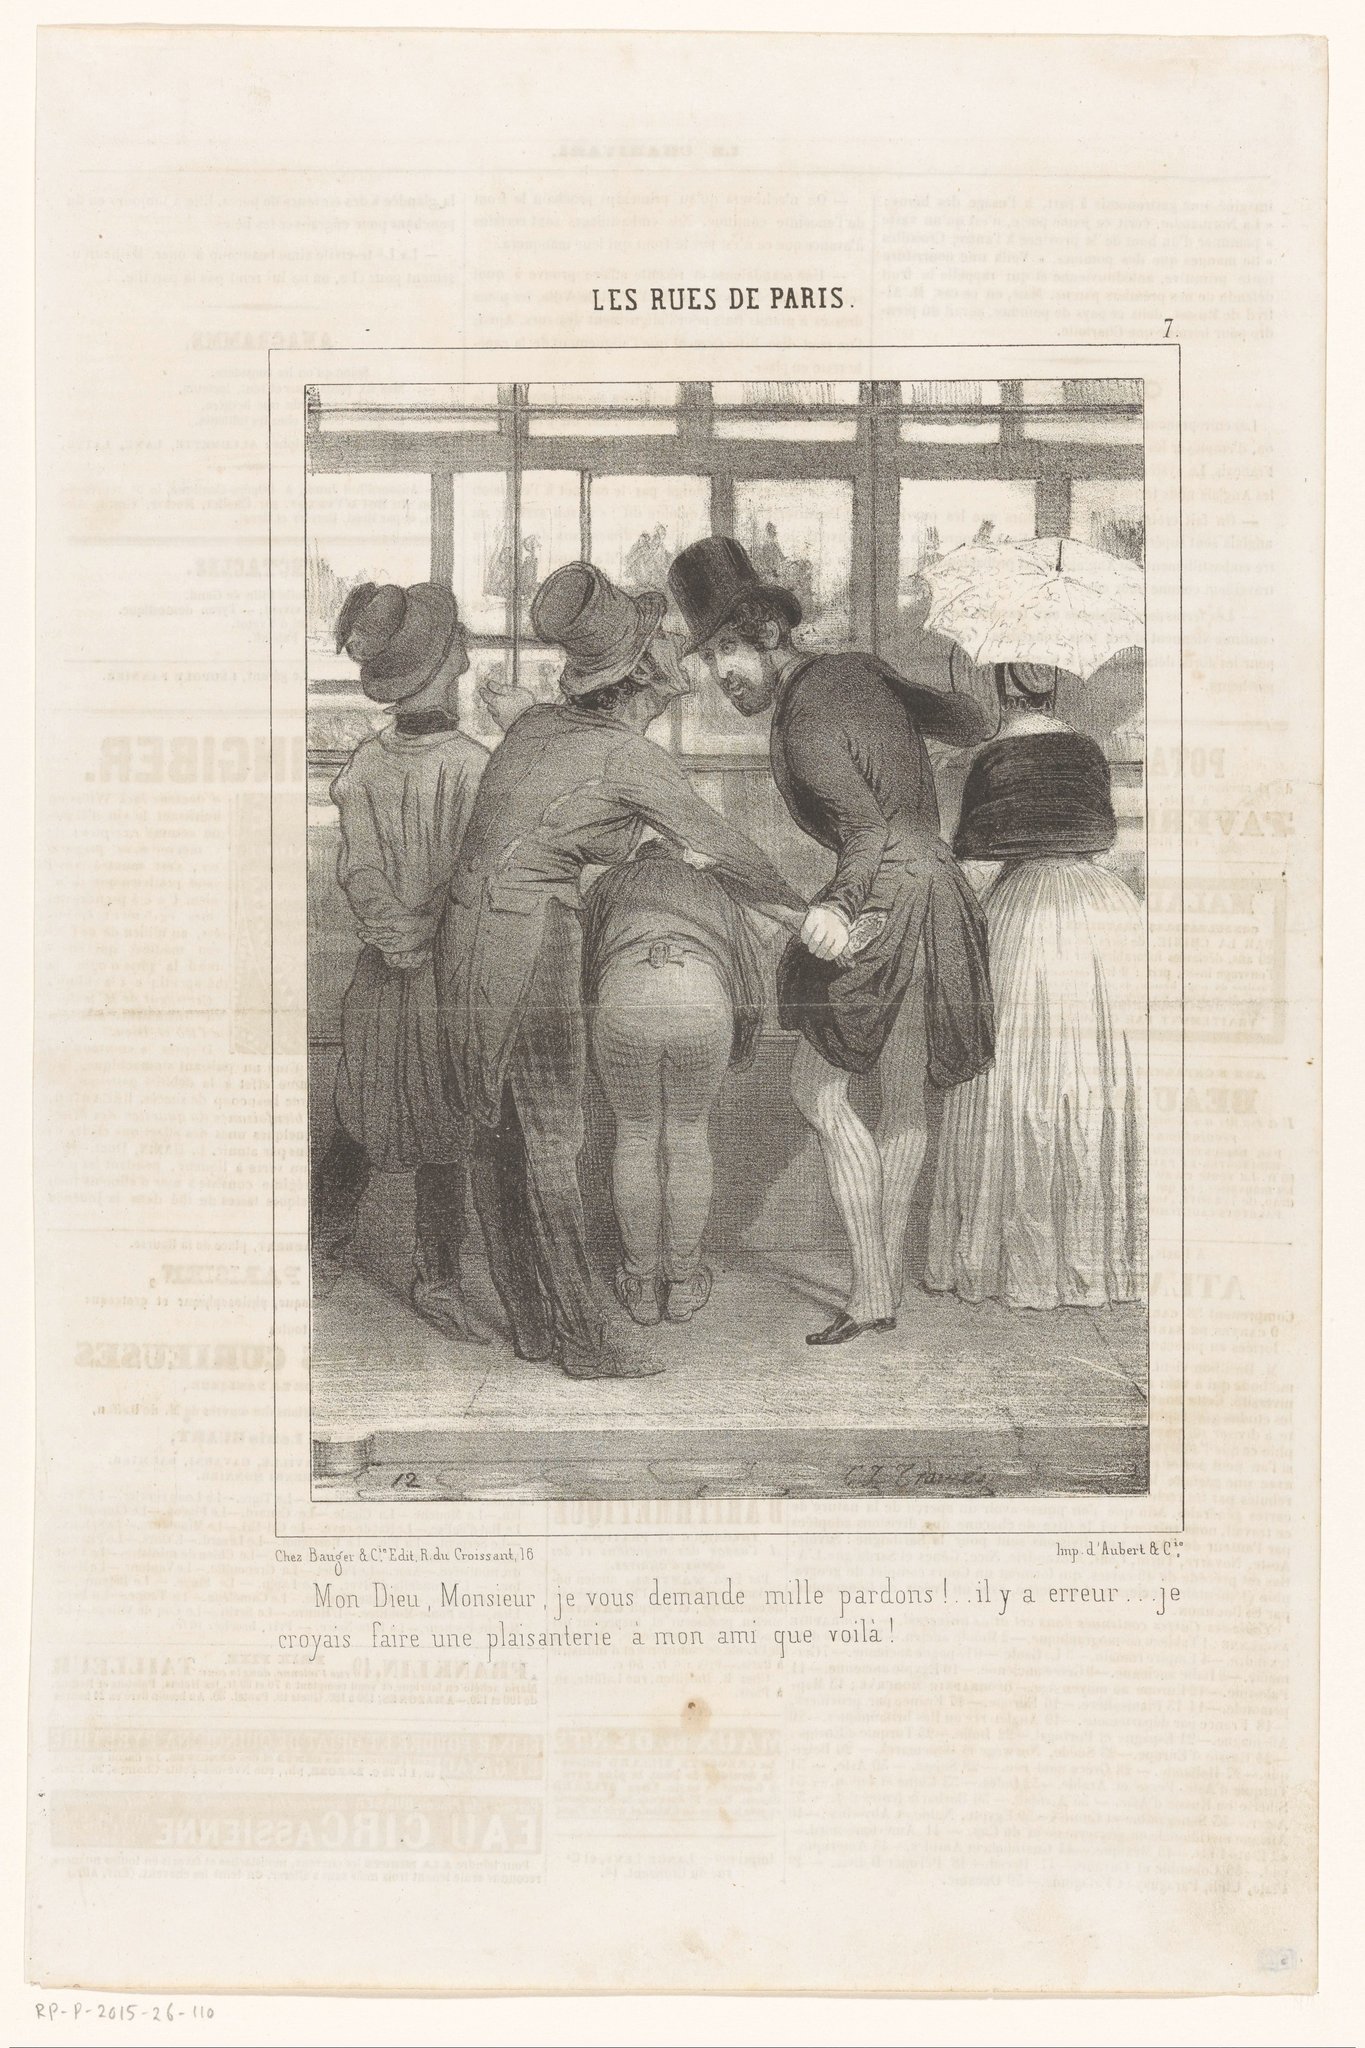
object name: print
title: Zakkenroller voor de etalage van een prenthandel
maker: charles-joseph traviès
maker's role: print maker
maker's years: 1804-1859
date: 1842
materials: paper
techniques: letterpress printing, lithograph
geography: paris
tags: pickpocket, art dealer, shop-window, show-window, paris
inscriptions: collector's mark: Lugt 4780, collector's mark: Lugt 4779, collector's mark: Lugt 2228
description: Prent uit: Le Charivari, 31 oktober 1842.